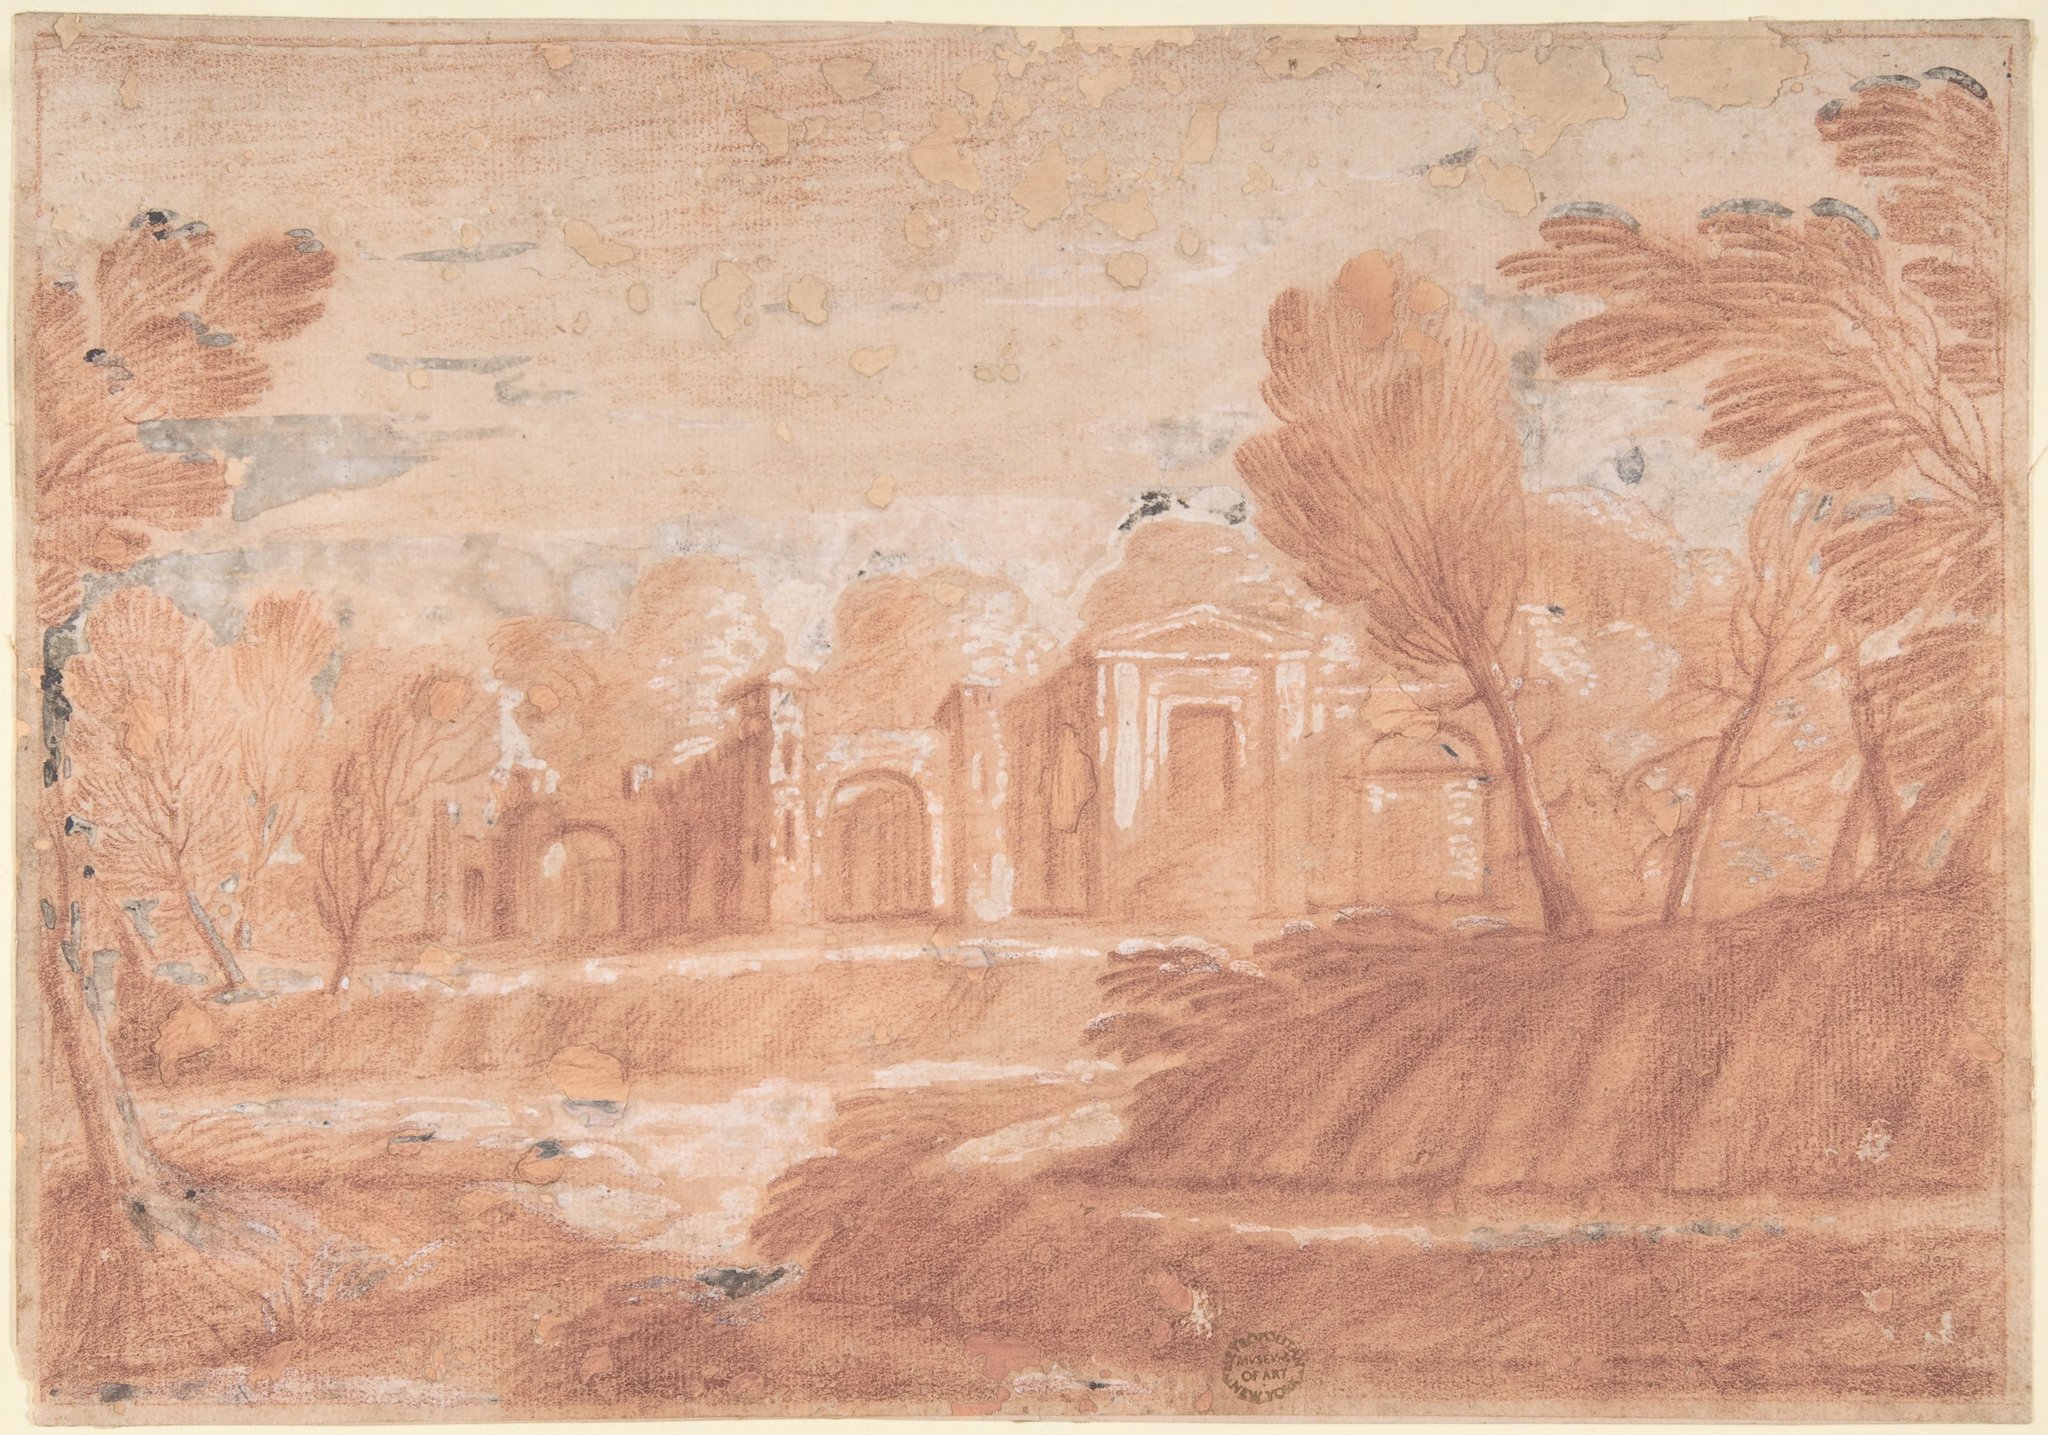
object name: drawing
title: Landscape with Architectural Structure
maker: anonymous, italian, roman-bolognese, 17th century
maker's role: artist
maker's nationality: italian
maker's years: 1600-1700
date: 1601-1700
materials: chalk, gouache, paper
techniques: printmaking, highlighting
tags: buildings,landscapes,trees